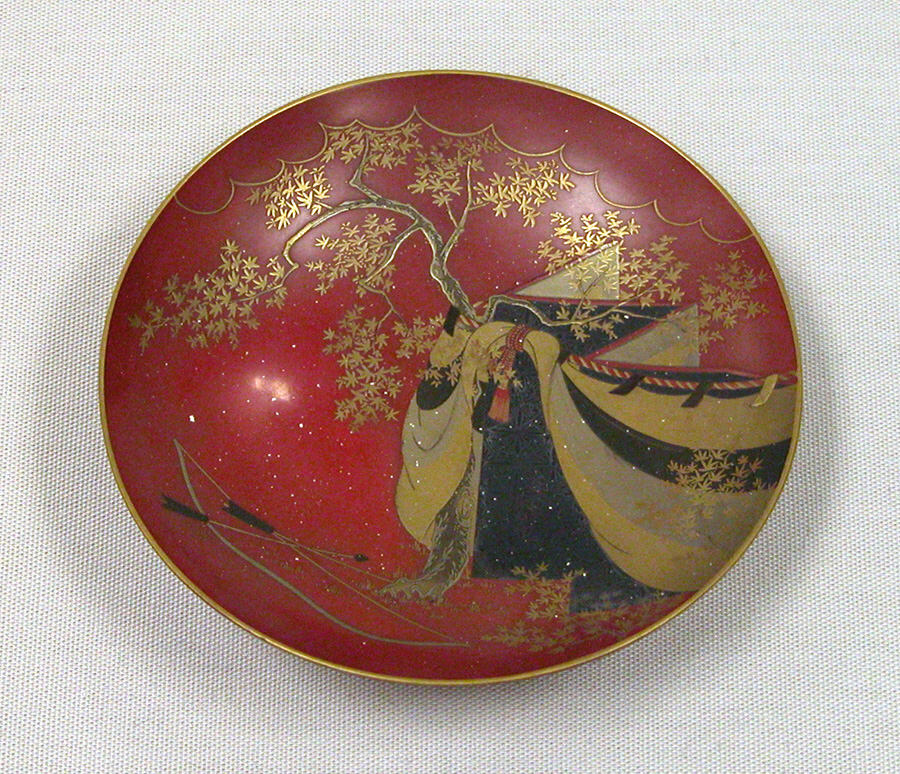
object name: wine cup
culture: japanese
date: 1834-1866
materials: gold, lacquer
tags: tents,bow and arrow,trees